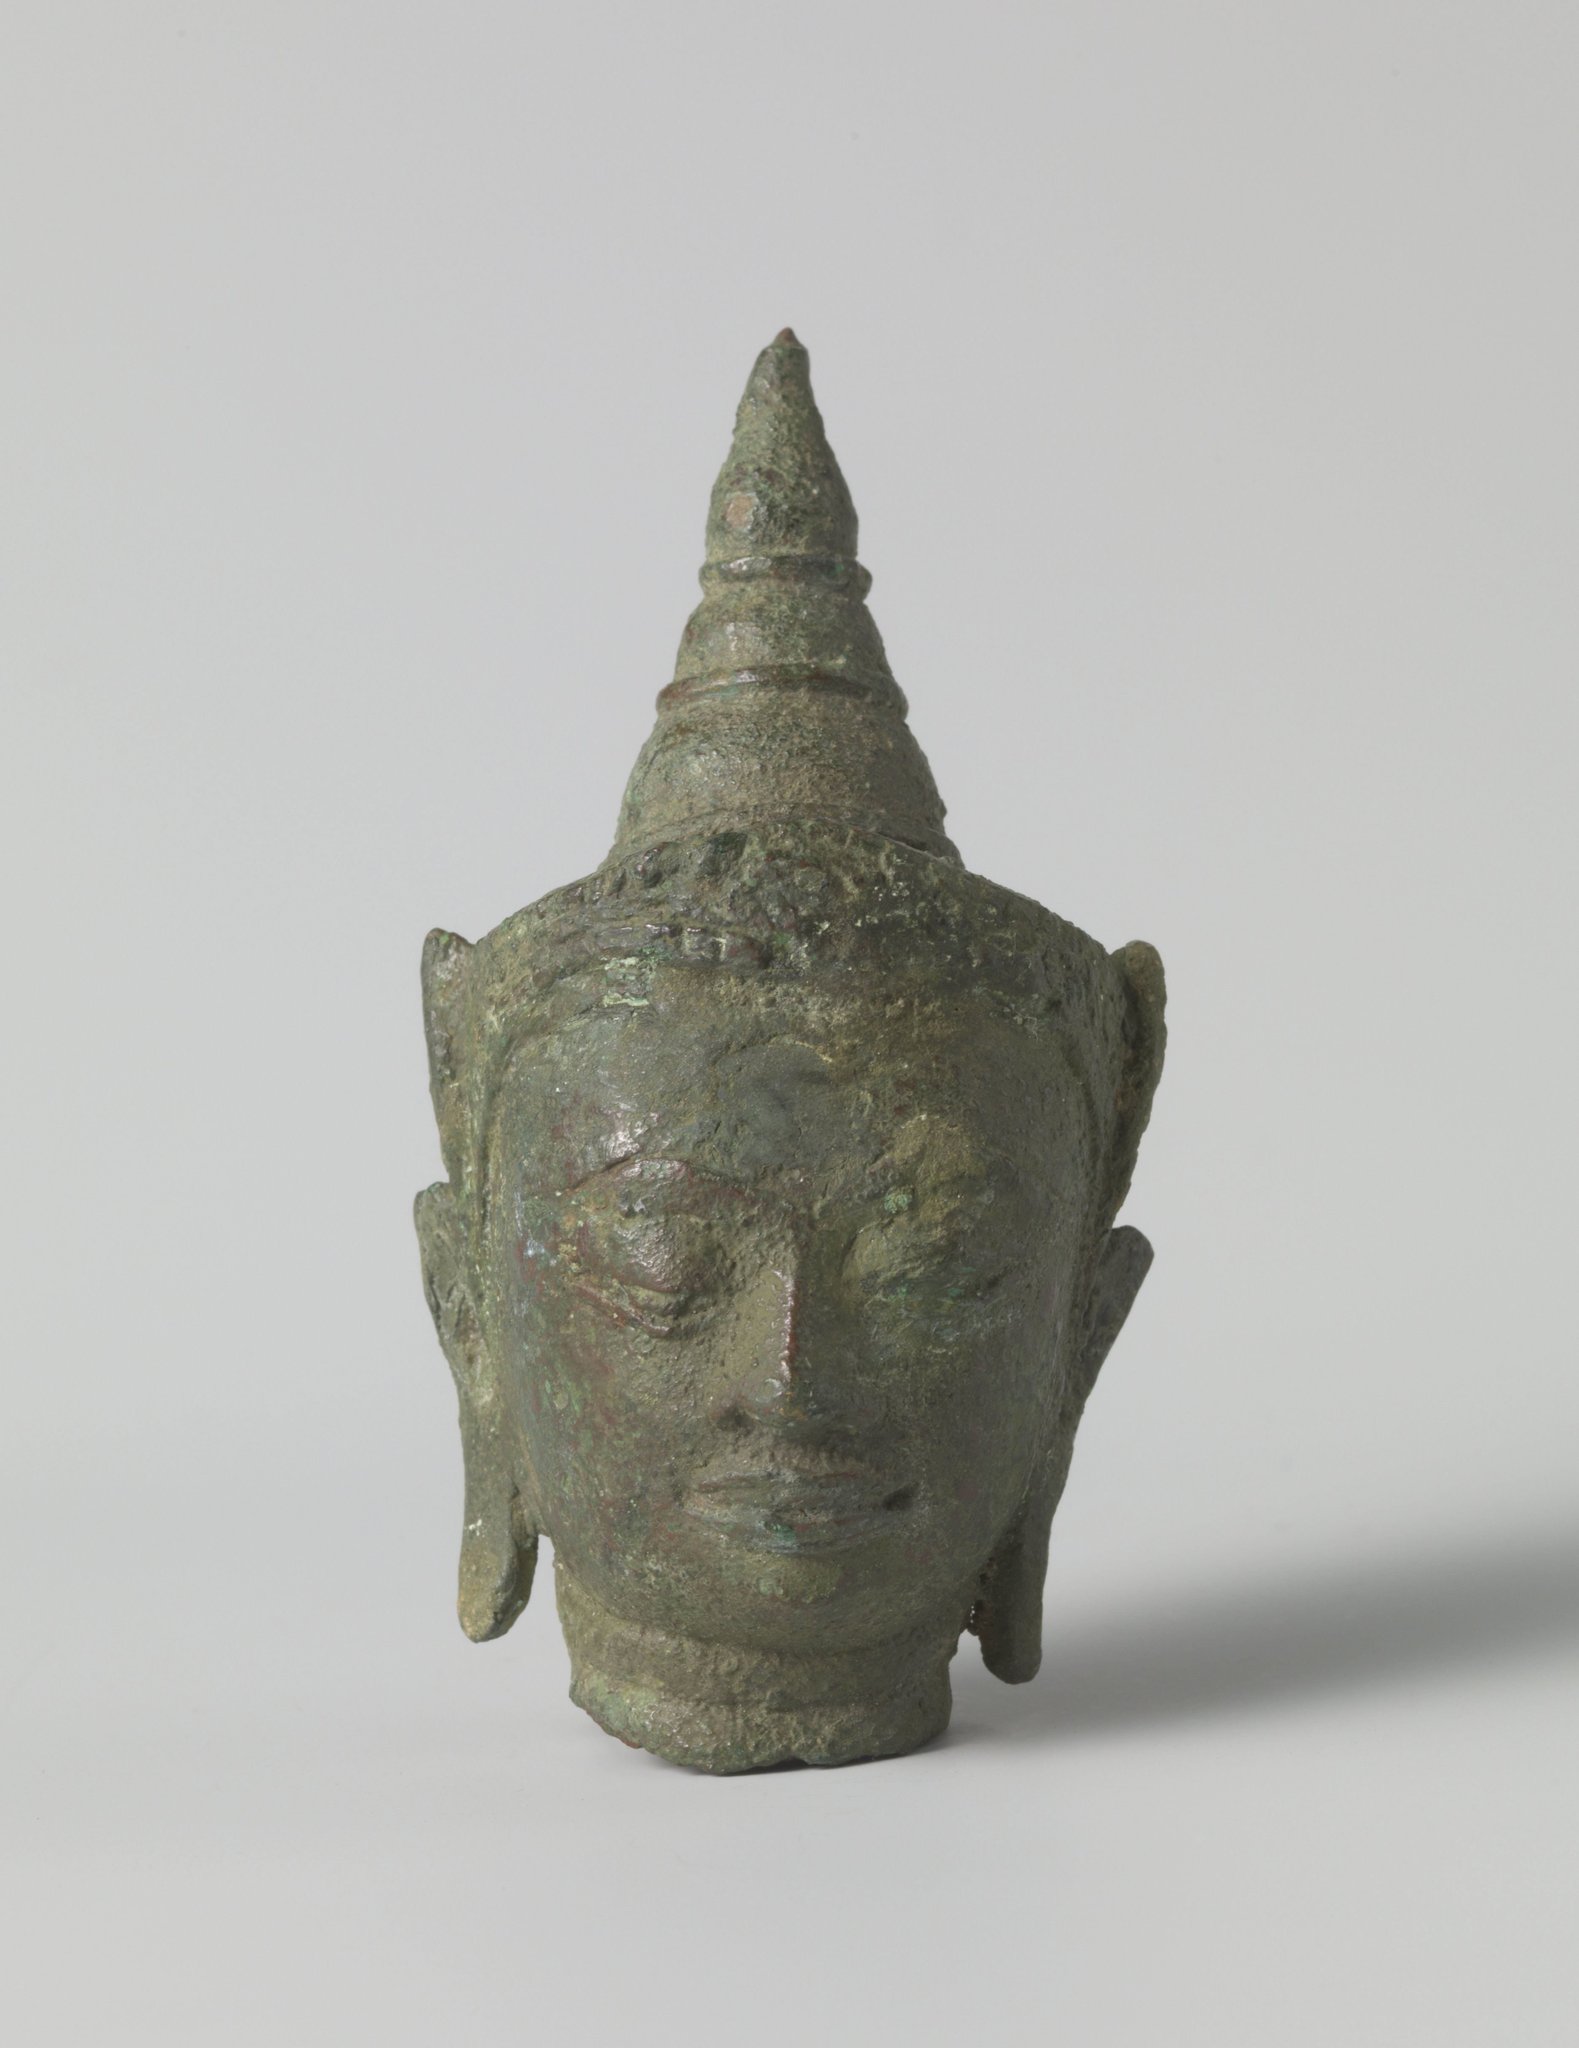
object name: fragment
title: Fragment van een boeddha-beeld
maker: Anonymous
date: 1500-1700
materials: bronze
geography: thailand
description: Boeddha-hoofd met spitstoelopende hoofdtooi.